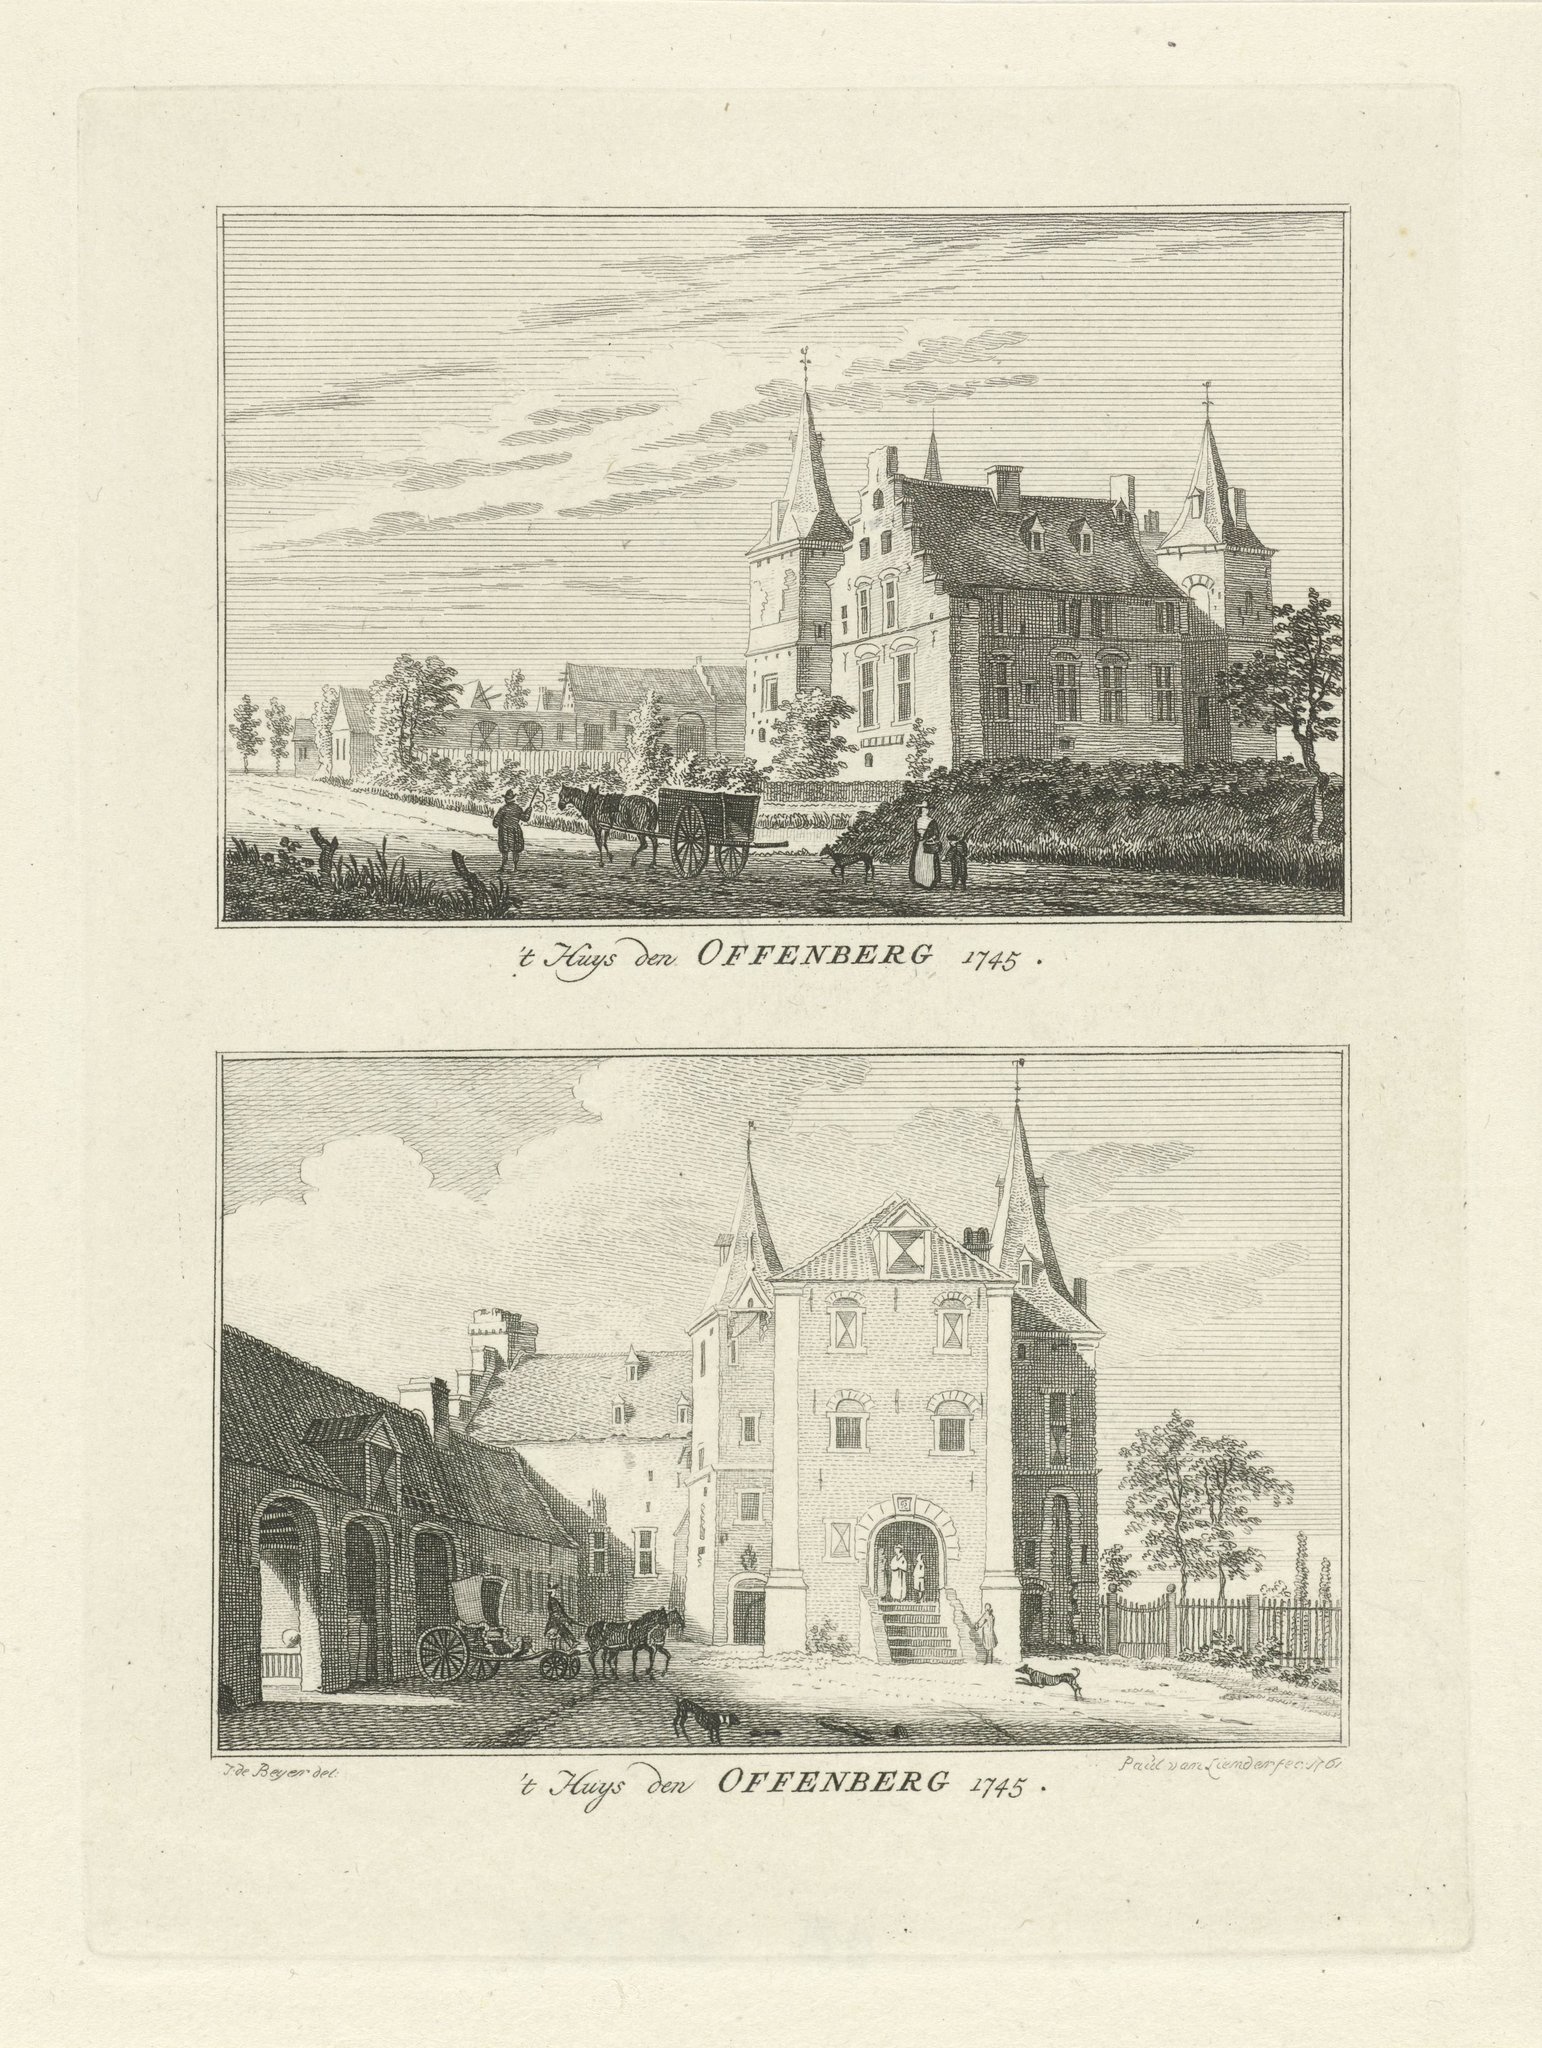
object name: print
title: 't Huys den Offenberg 1745/ 't Huys den Offenberg 1745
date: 1761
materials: paper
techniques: etching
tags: landscape with tower or castle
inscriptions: collector's mark: Lugt 240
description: Twee voorstellingen van één plaat. Twee gezichten op Kasteel Offenberg te Duitsland. De prent maakt deel uit van een 100-delige serie met gezichten op dorpen en steden te Kleef.